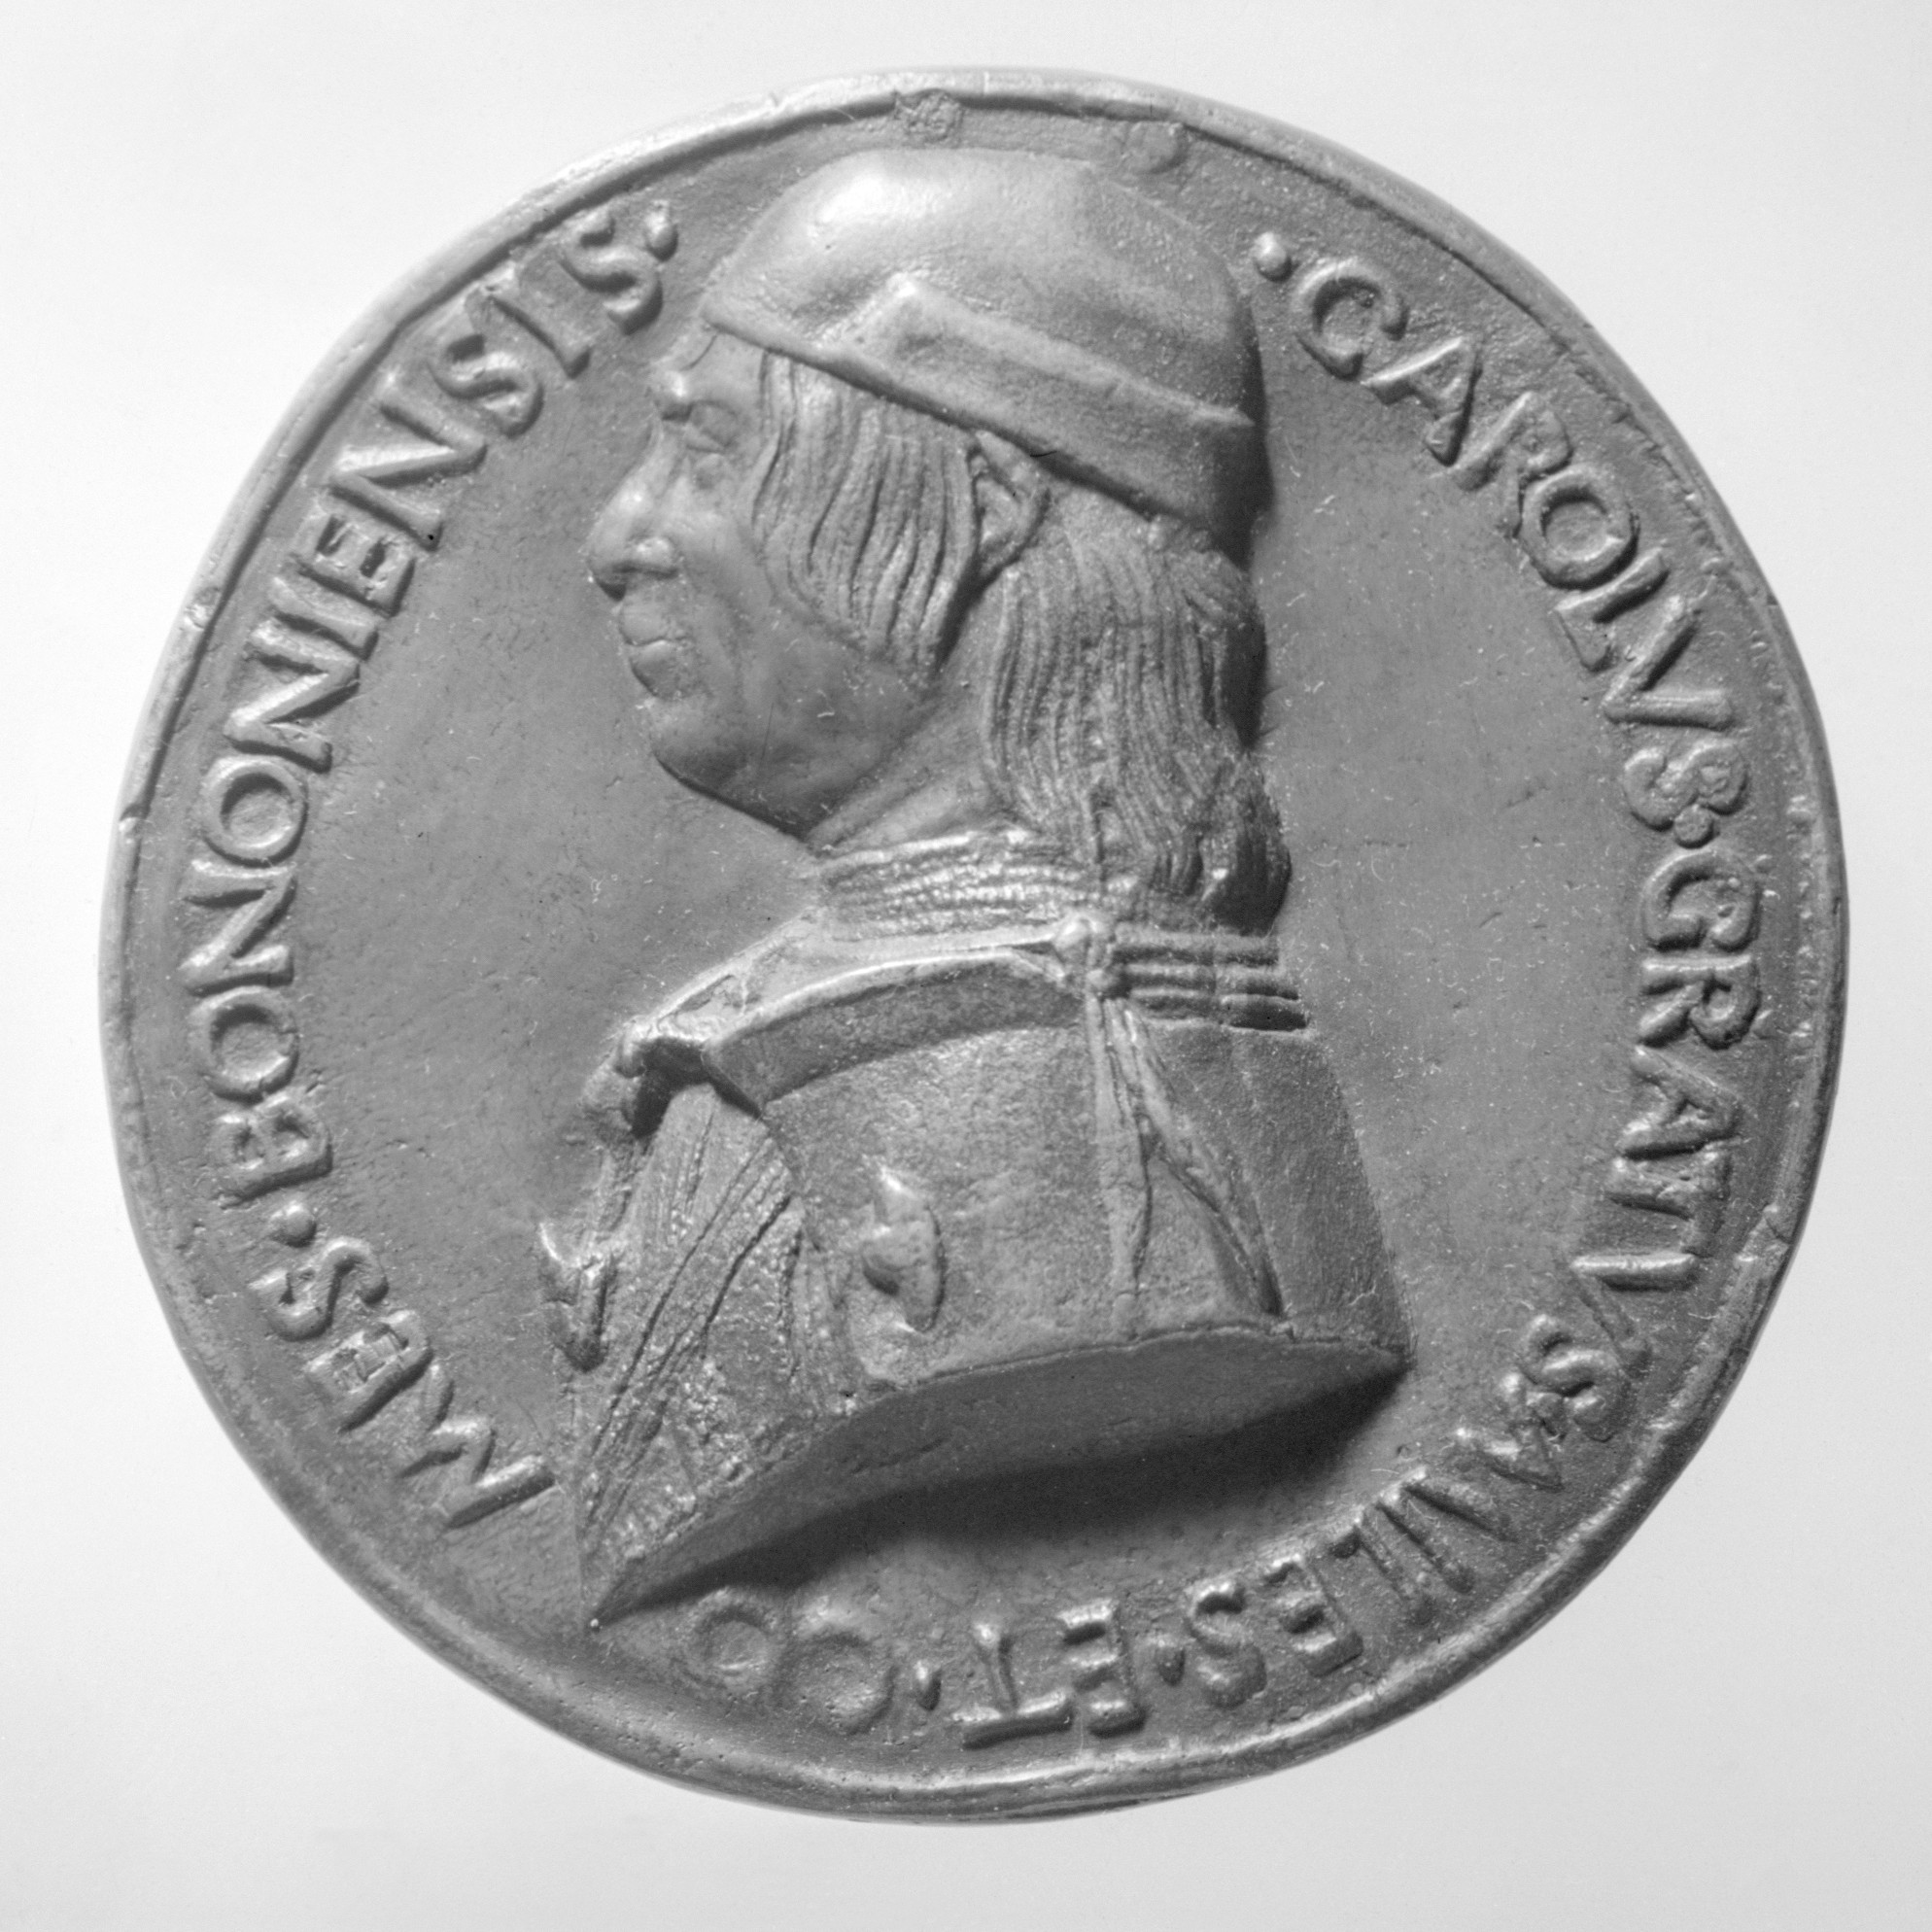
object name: medal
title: Carlo Grati, noble of Bologna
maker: savelli sperandio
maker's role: artist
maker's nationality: italian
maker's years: 1425-1504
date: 1485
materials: bronze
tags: men,profiles